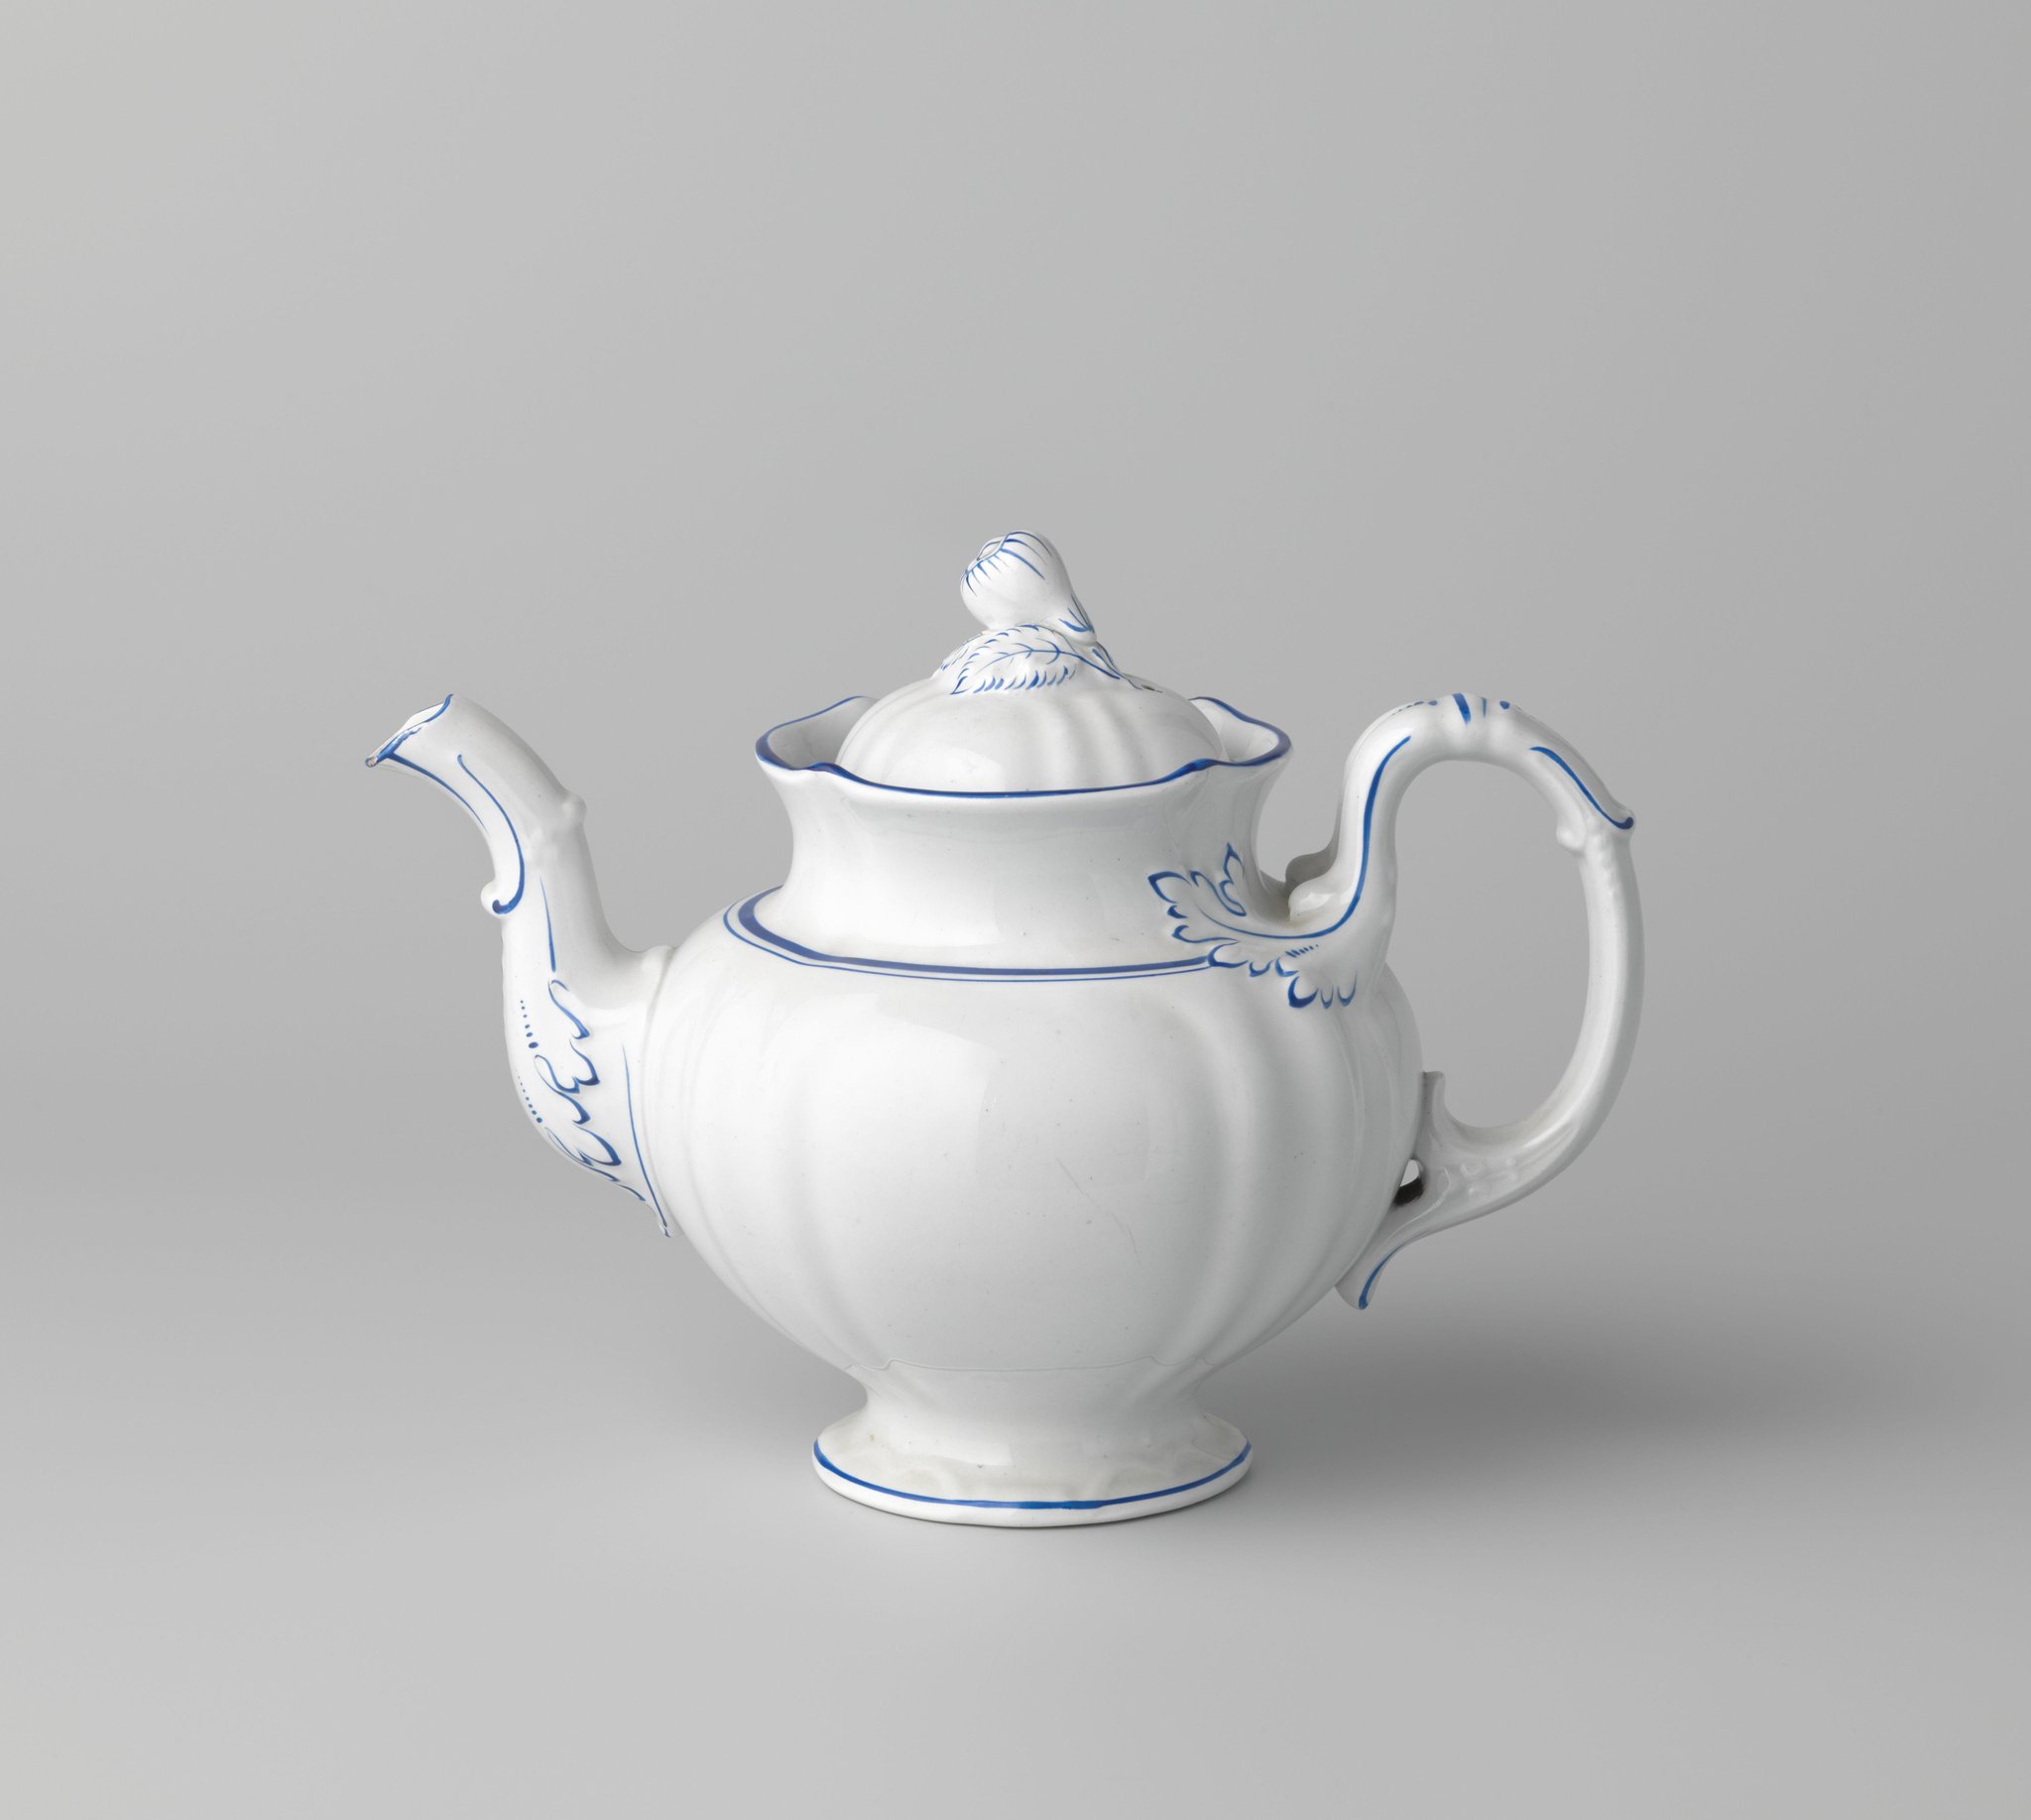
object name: teapot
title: Theepot met deksel, wit, met blauwe biezen en peervormige dekselknop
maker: petrus regout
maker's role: plateelbakker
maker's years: 1801-1879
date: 1860-1890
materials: creamware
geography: maastricht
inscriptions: check stamp: ‘P. REGOUT // MAASTRICHT’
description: Theepot met deksel van aardewerk, behorend bij een koffie- en theeservies, wit, met blauwe biezen en peervormige dekselknop.